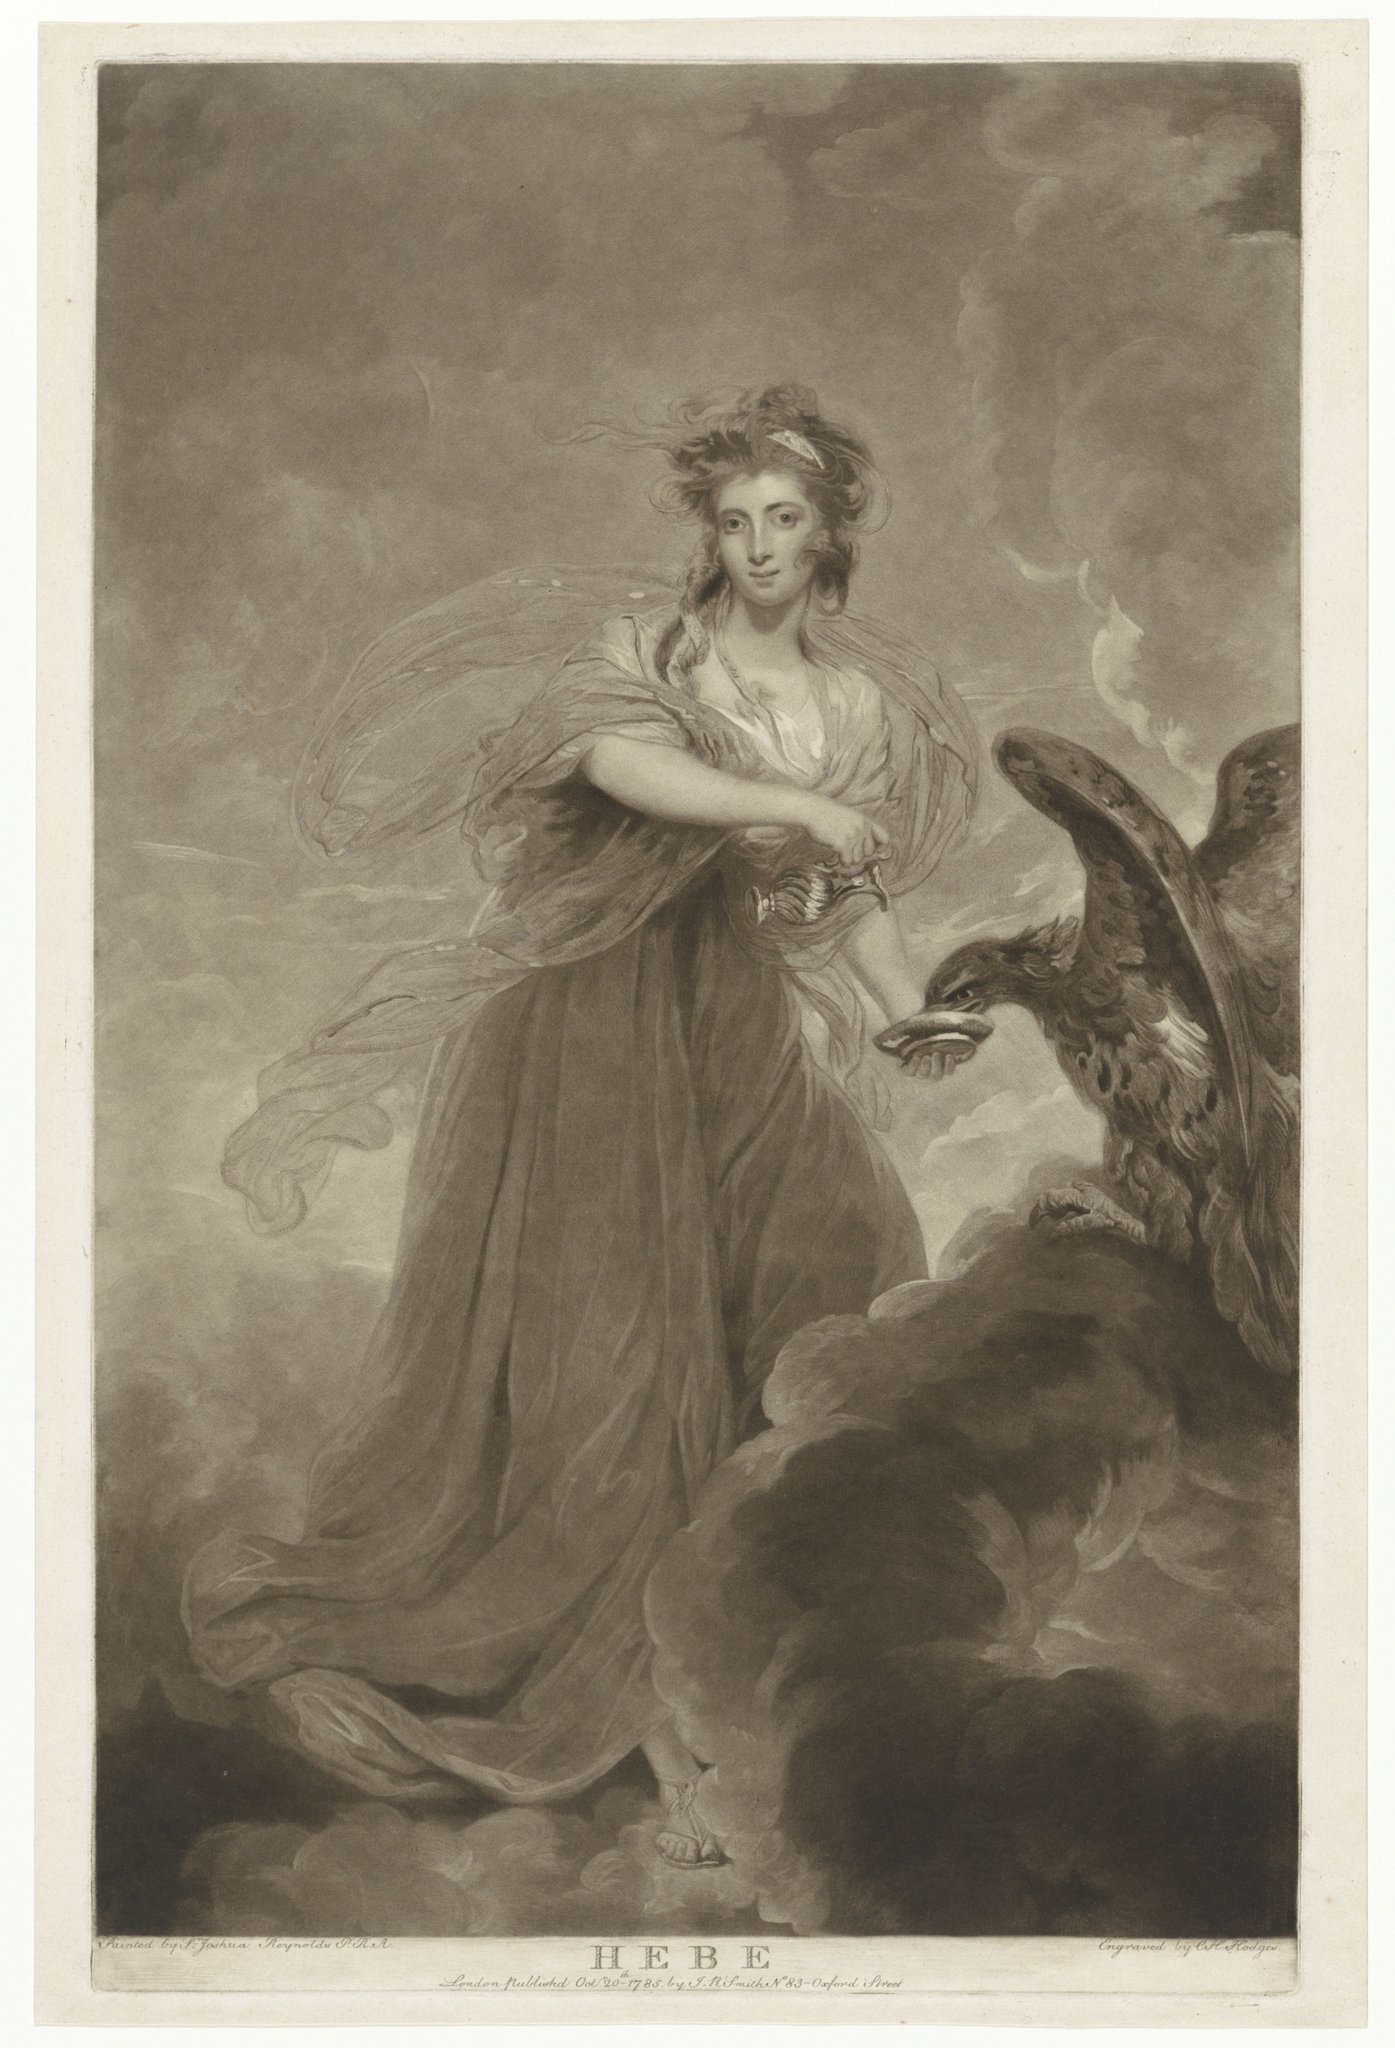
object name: print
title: Portret van Sophie Musters als Hebe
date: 1785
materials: paper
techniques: etching, roulette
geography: london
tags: england, (story of) hebe (juventas)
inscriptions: collector's mark: Lugt 2228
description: De actrice Sophie Catherine Musters als Hebe, de godin van de jeugd. Ze staat op de wolken en voert een arend water uit een schaal.